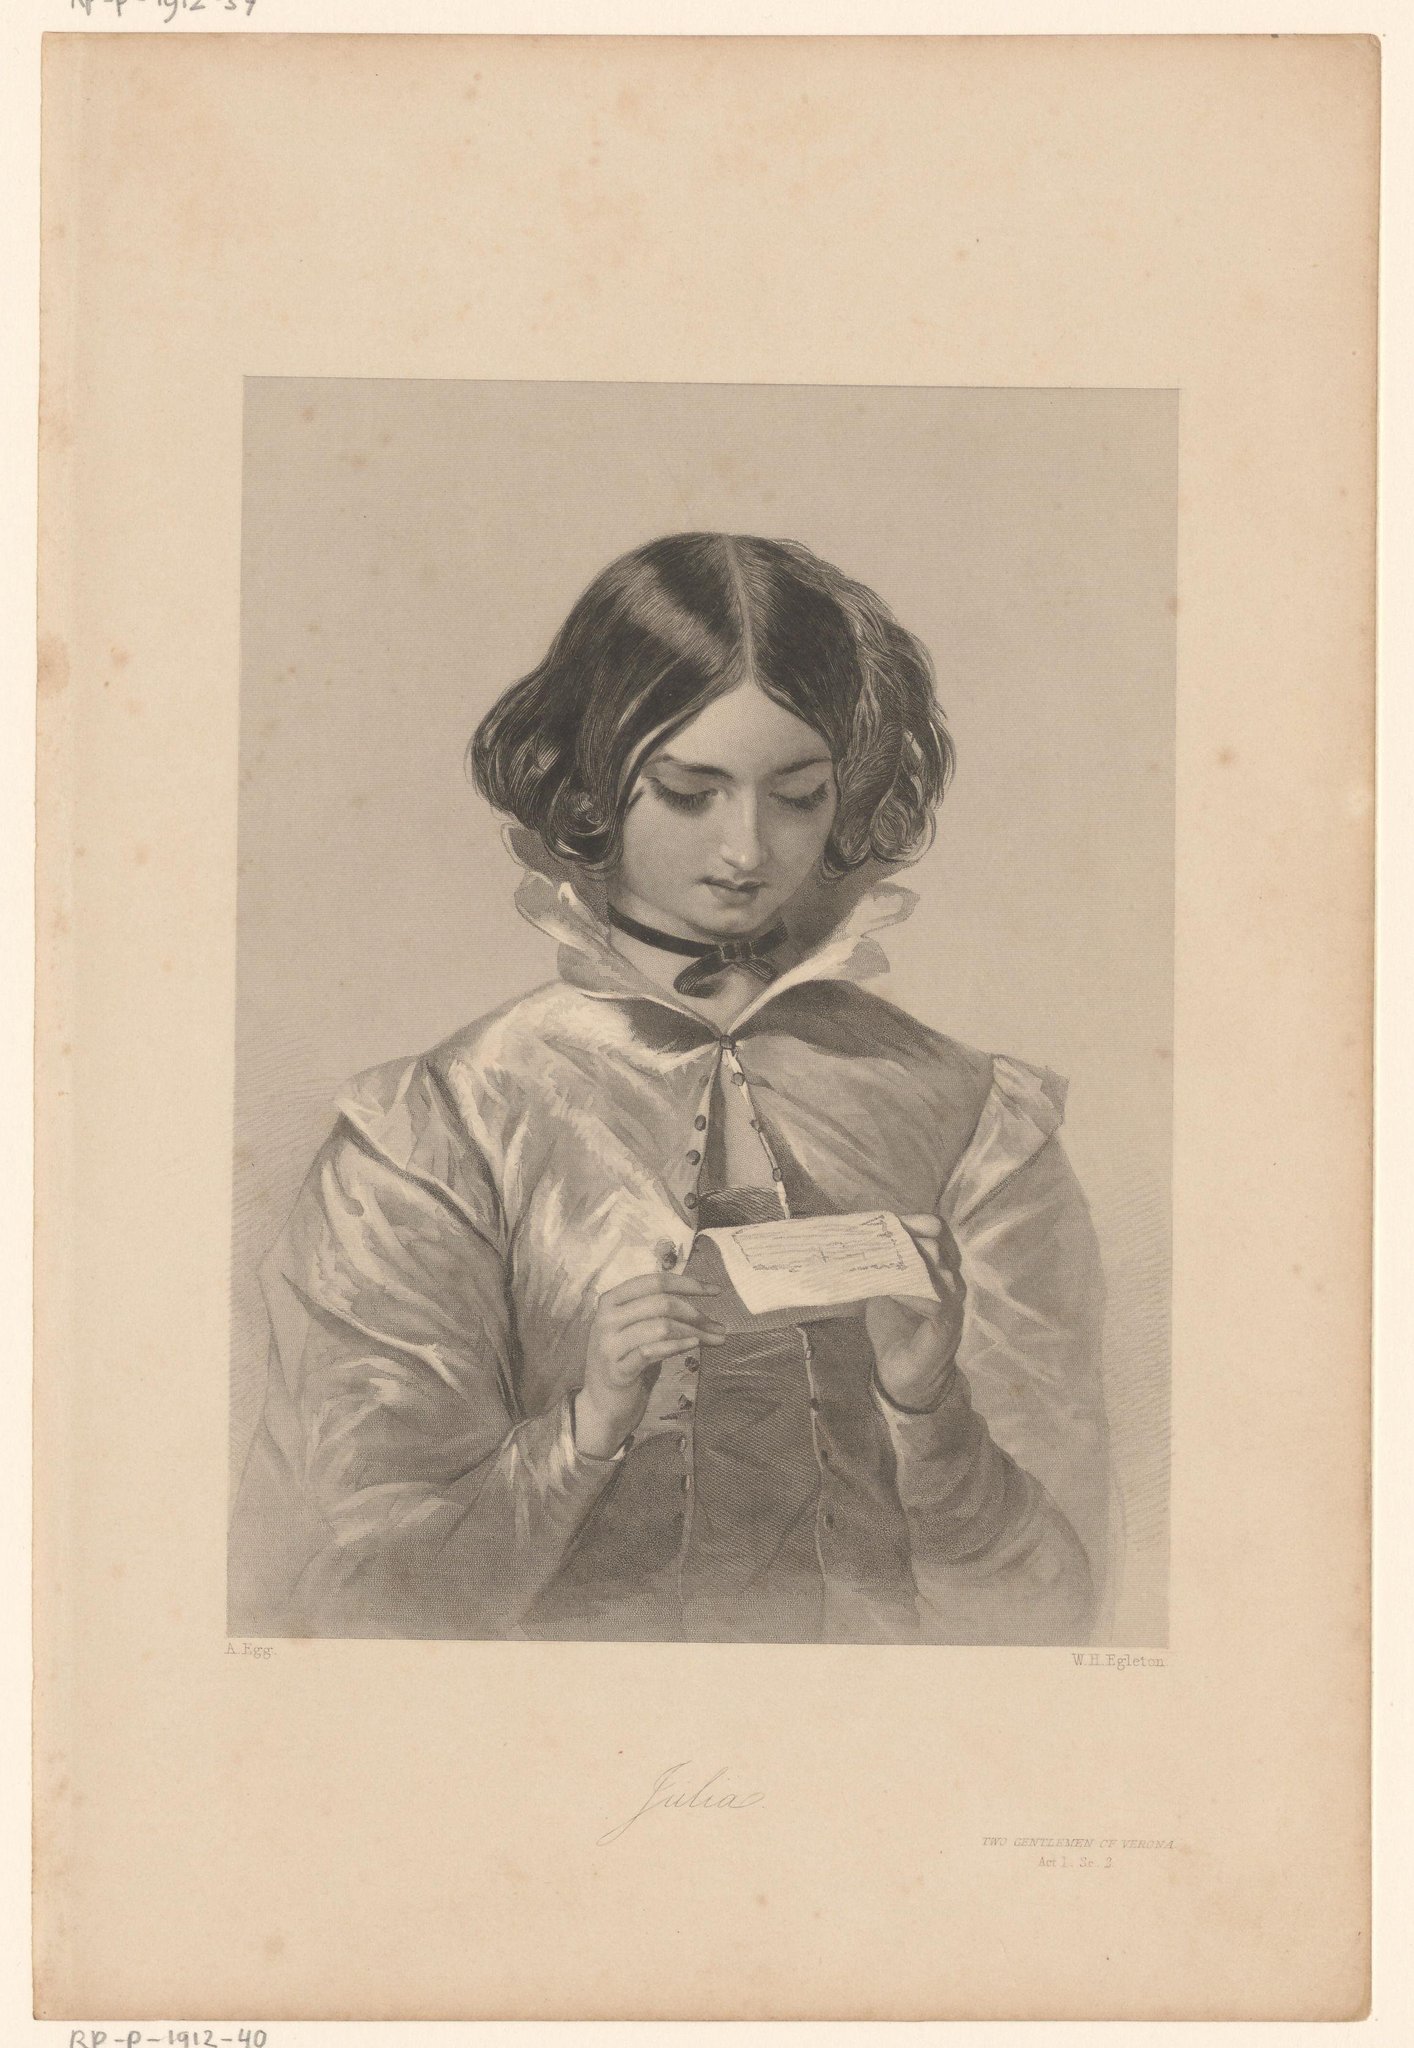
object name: print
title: Julia, uit Shakespeare's De twee Veronezen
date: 1847-1848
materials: paper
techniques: etching, roulette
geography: london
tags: william shakespeare, reading, female literary characters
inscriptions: collector's mark: Lugt 2228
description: Prent ook gebruikt in: Heath, Charles. The heroines of Shakespeare: comprising the principal female characters in the plays of the great poet. Londen: David Bogue, 1848.